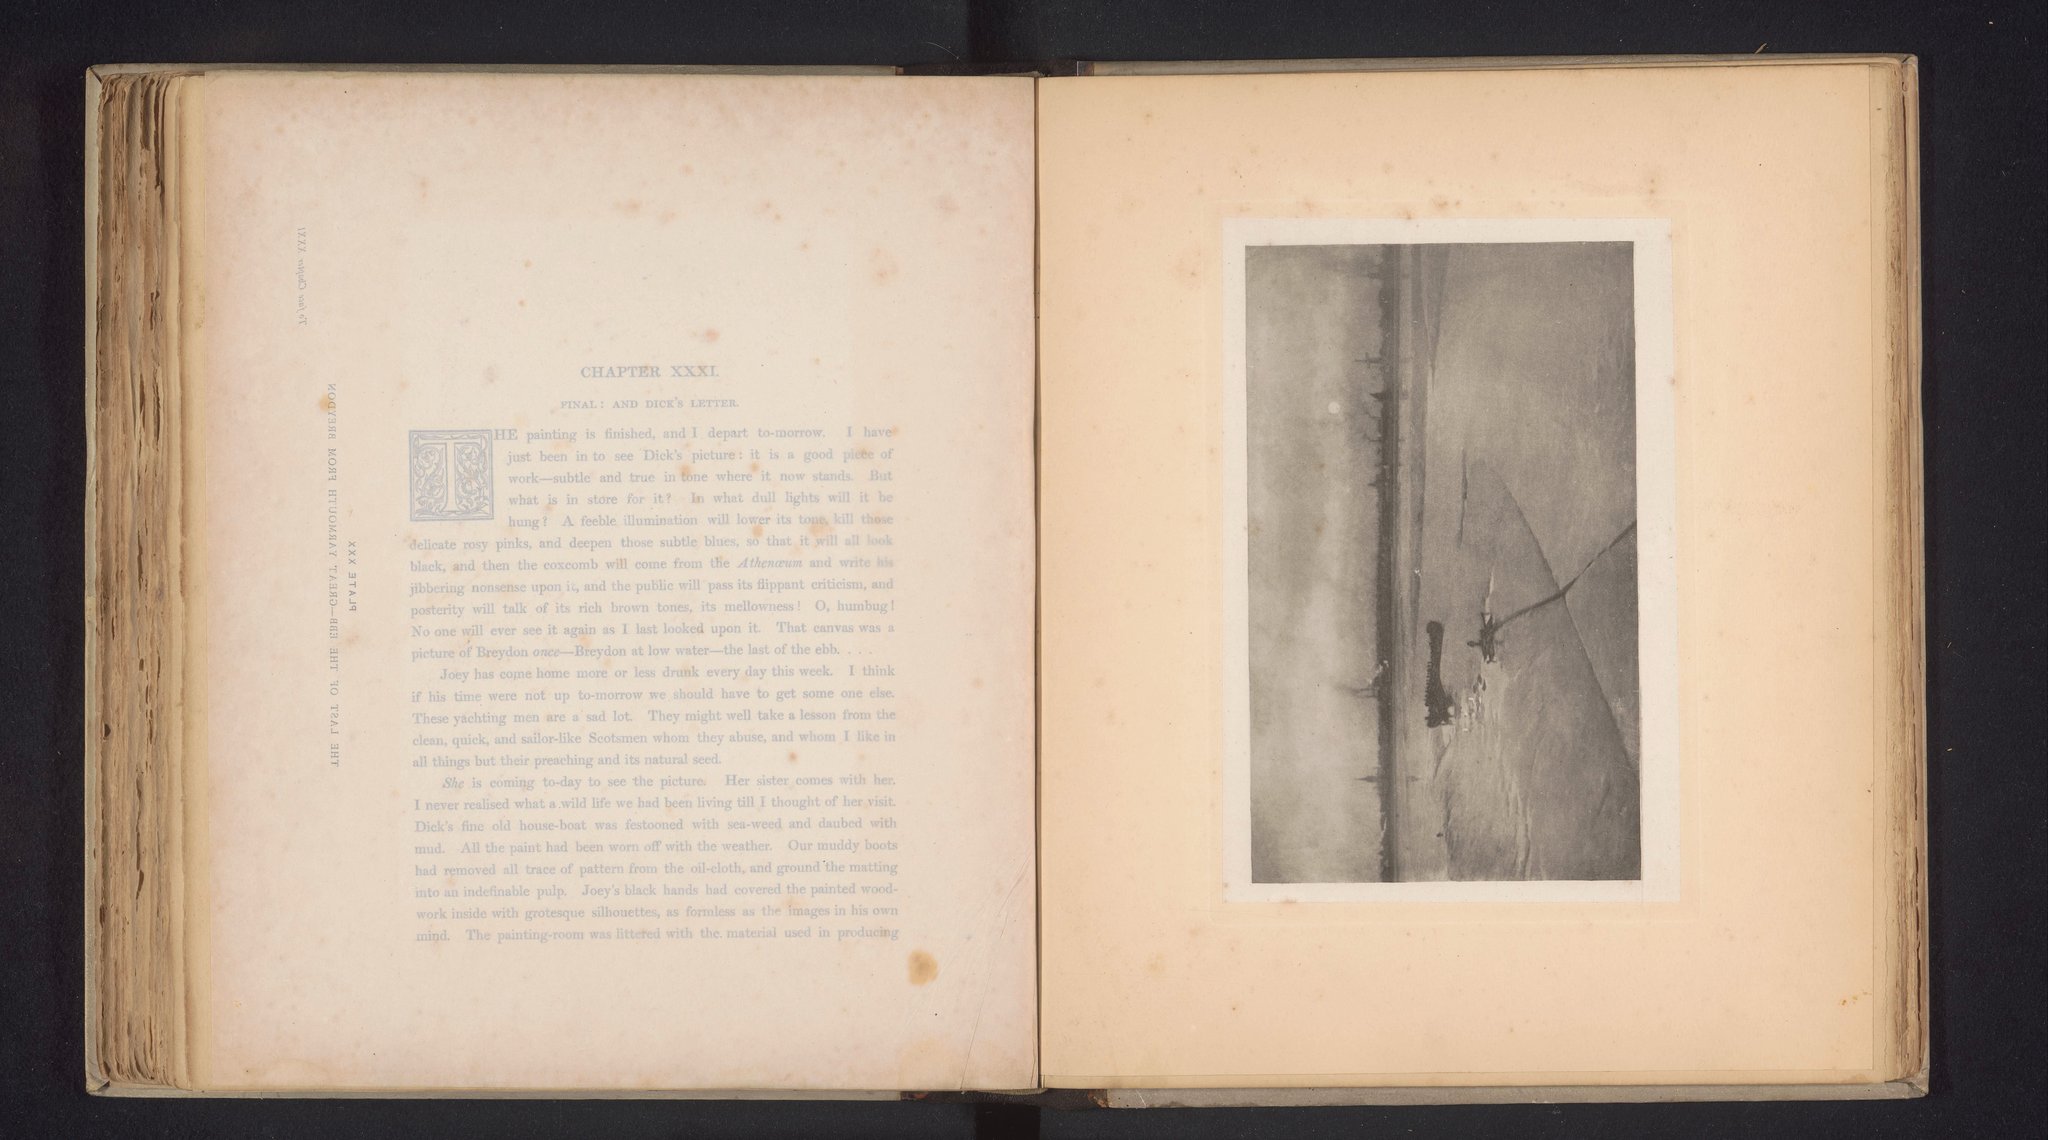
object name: page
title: Gezicht op Great Yarmouth, met op de voorgrond de Breydon bij eb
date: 1880-1890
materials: paper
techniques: photoaquatint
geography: norfolk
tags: city-view in general; 'veduta'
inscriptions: number: ‘Plate XXX’, inscription: ‘The last of the ebb-Great Yarmouth from Breydon’